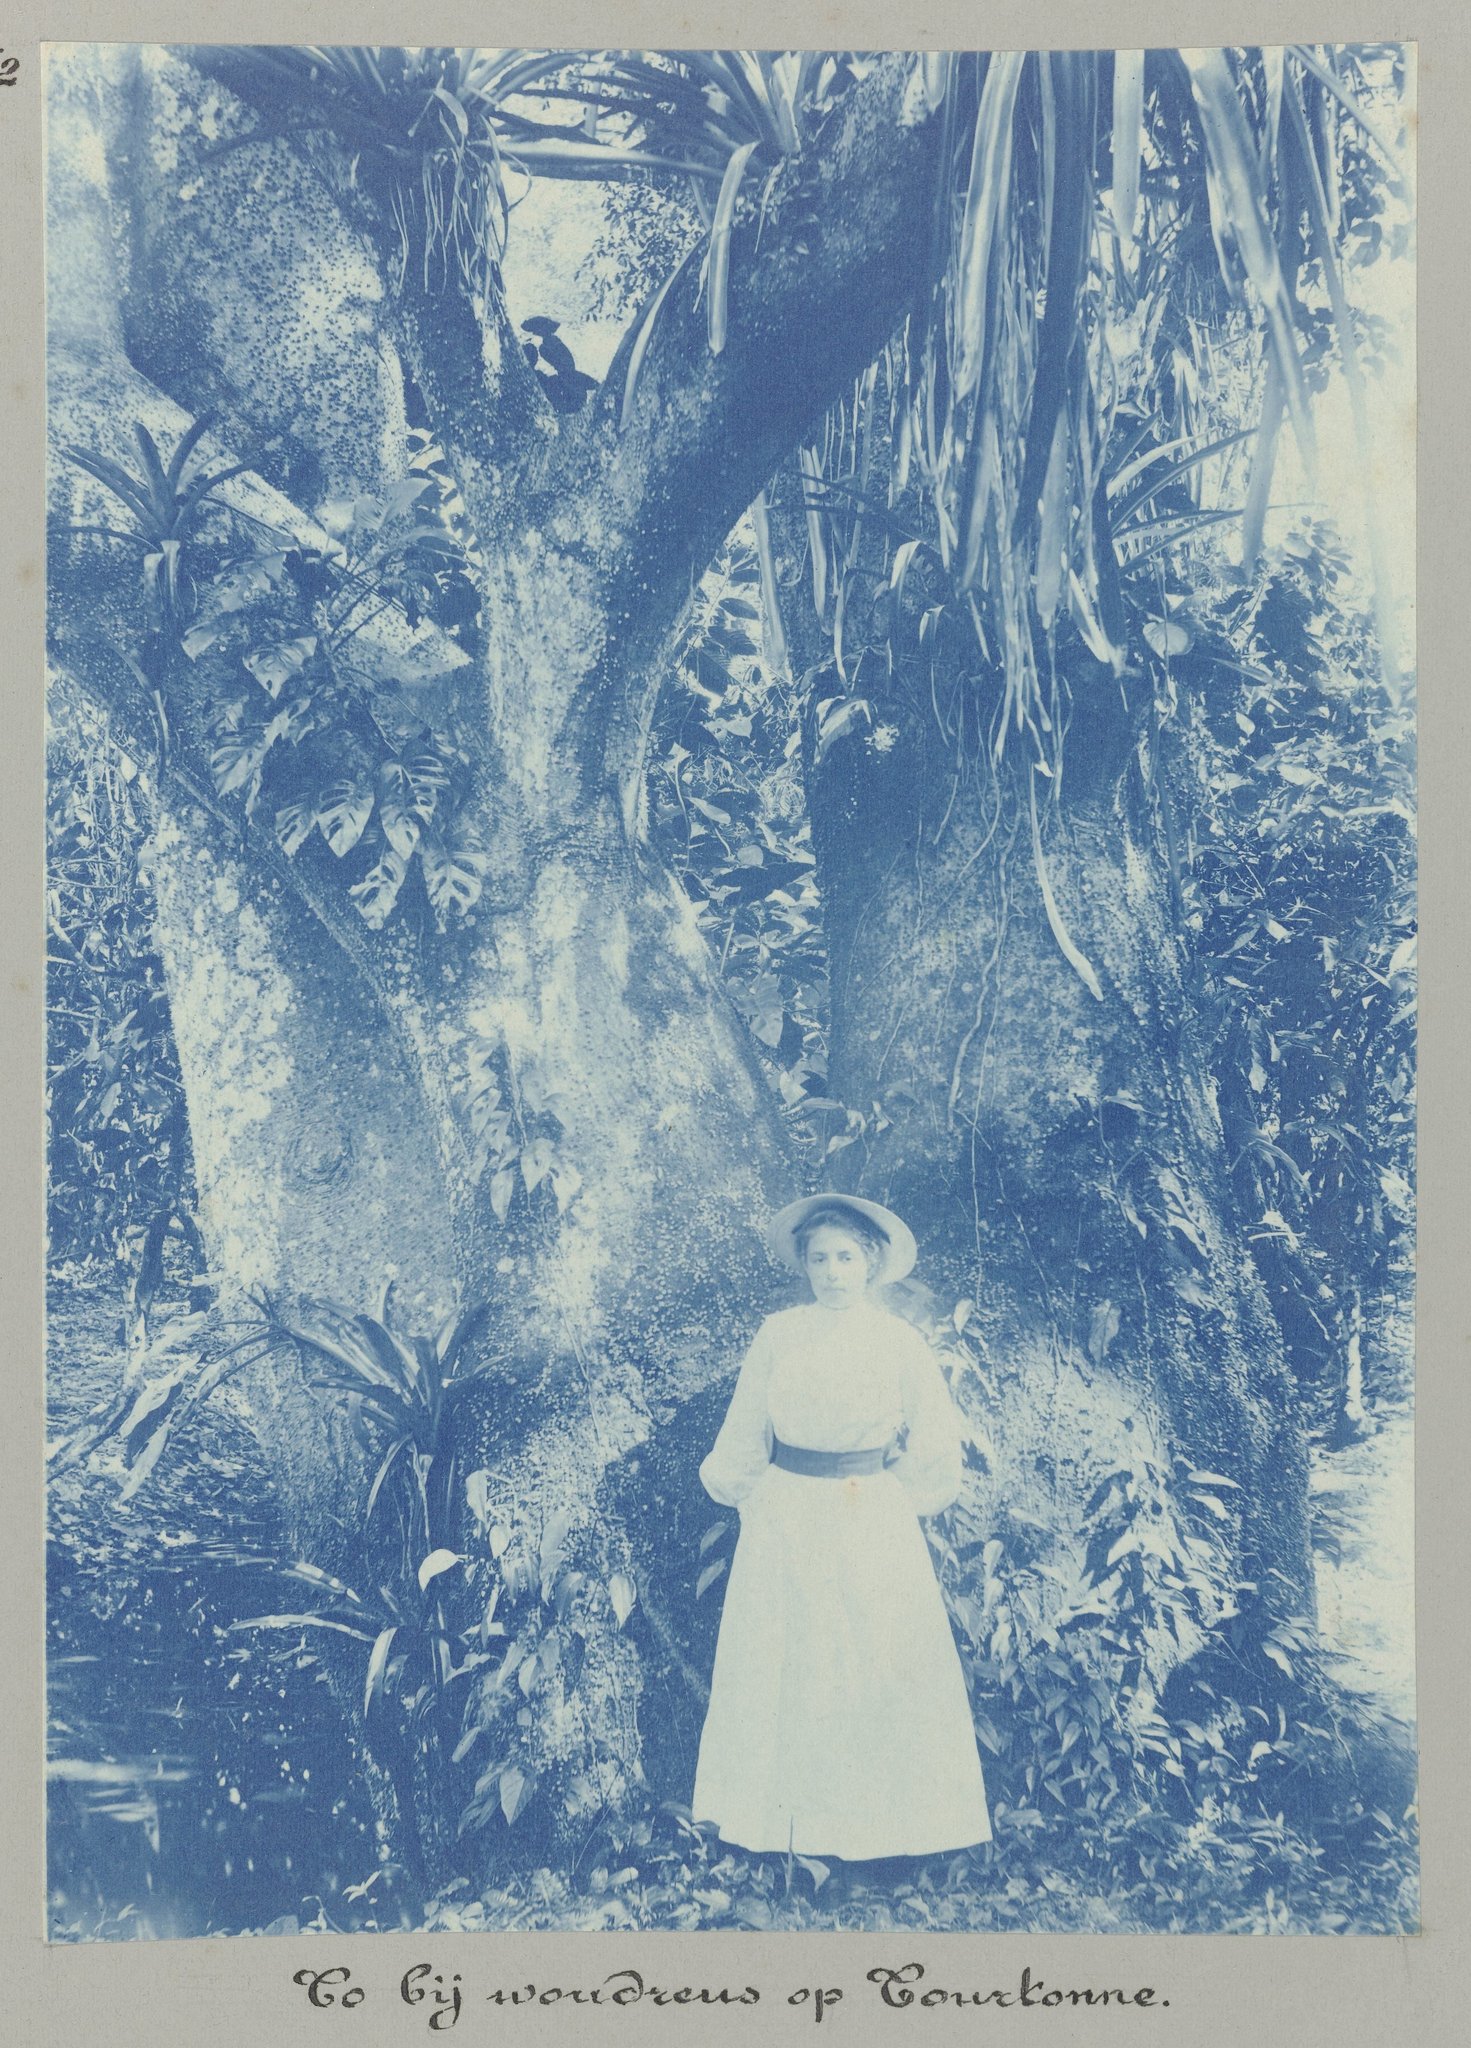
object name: photograph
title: To bij woudreus op Tourtonne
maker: hendrik doijer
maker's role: engineer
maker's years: 1863-1925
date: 1903-1910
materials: photographic support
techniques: cyanotype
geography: suriname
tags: suriname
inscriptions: inscription: ‘E2 / To bij woudreus op Tourtonne.’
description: Een Nederlandse jonge vrouw genaamd To poserend voor een grote boom op de Plantage Tourtonne. Onderdeel van het fotoalbum Souvenir de Voyage (deel 4), over het leven van de familie Doijer in en rond de plantage Ma Retraite in Suriname in de jaren 1903-1910.